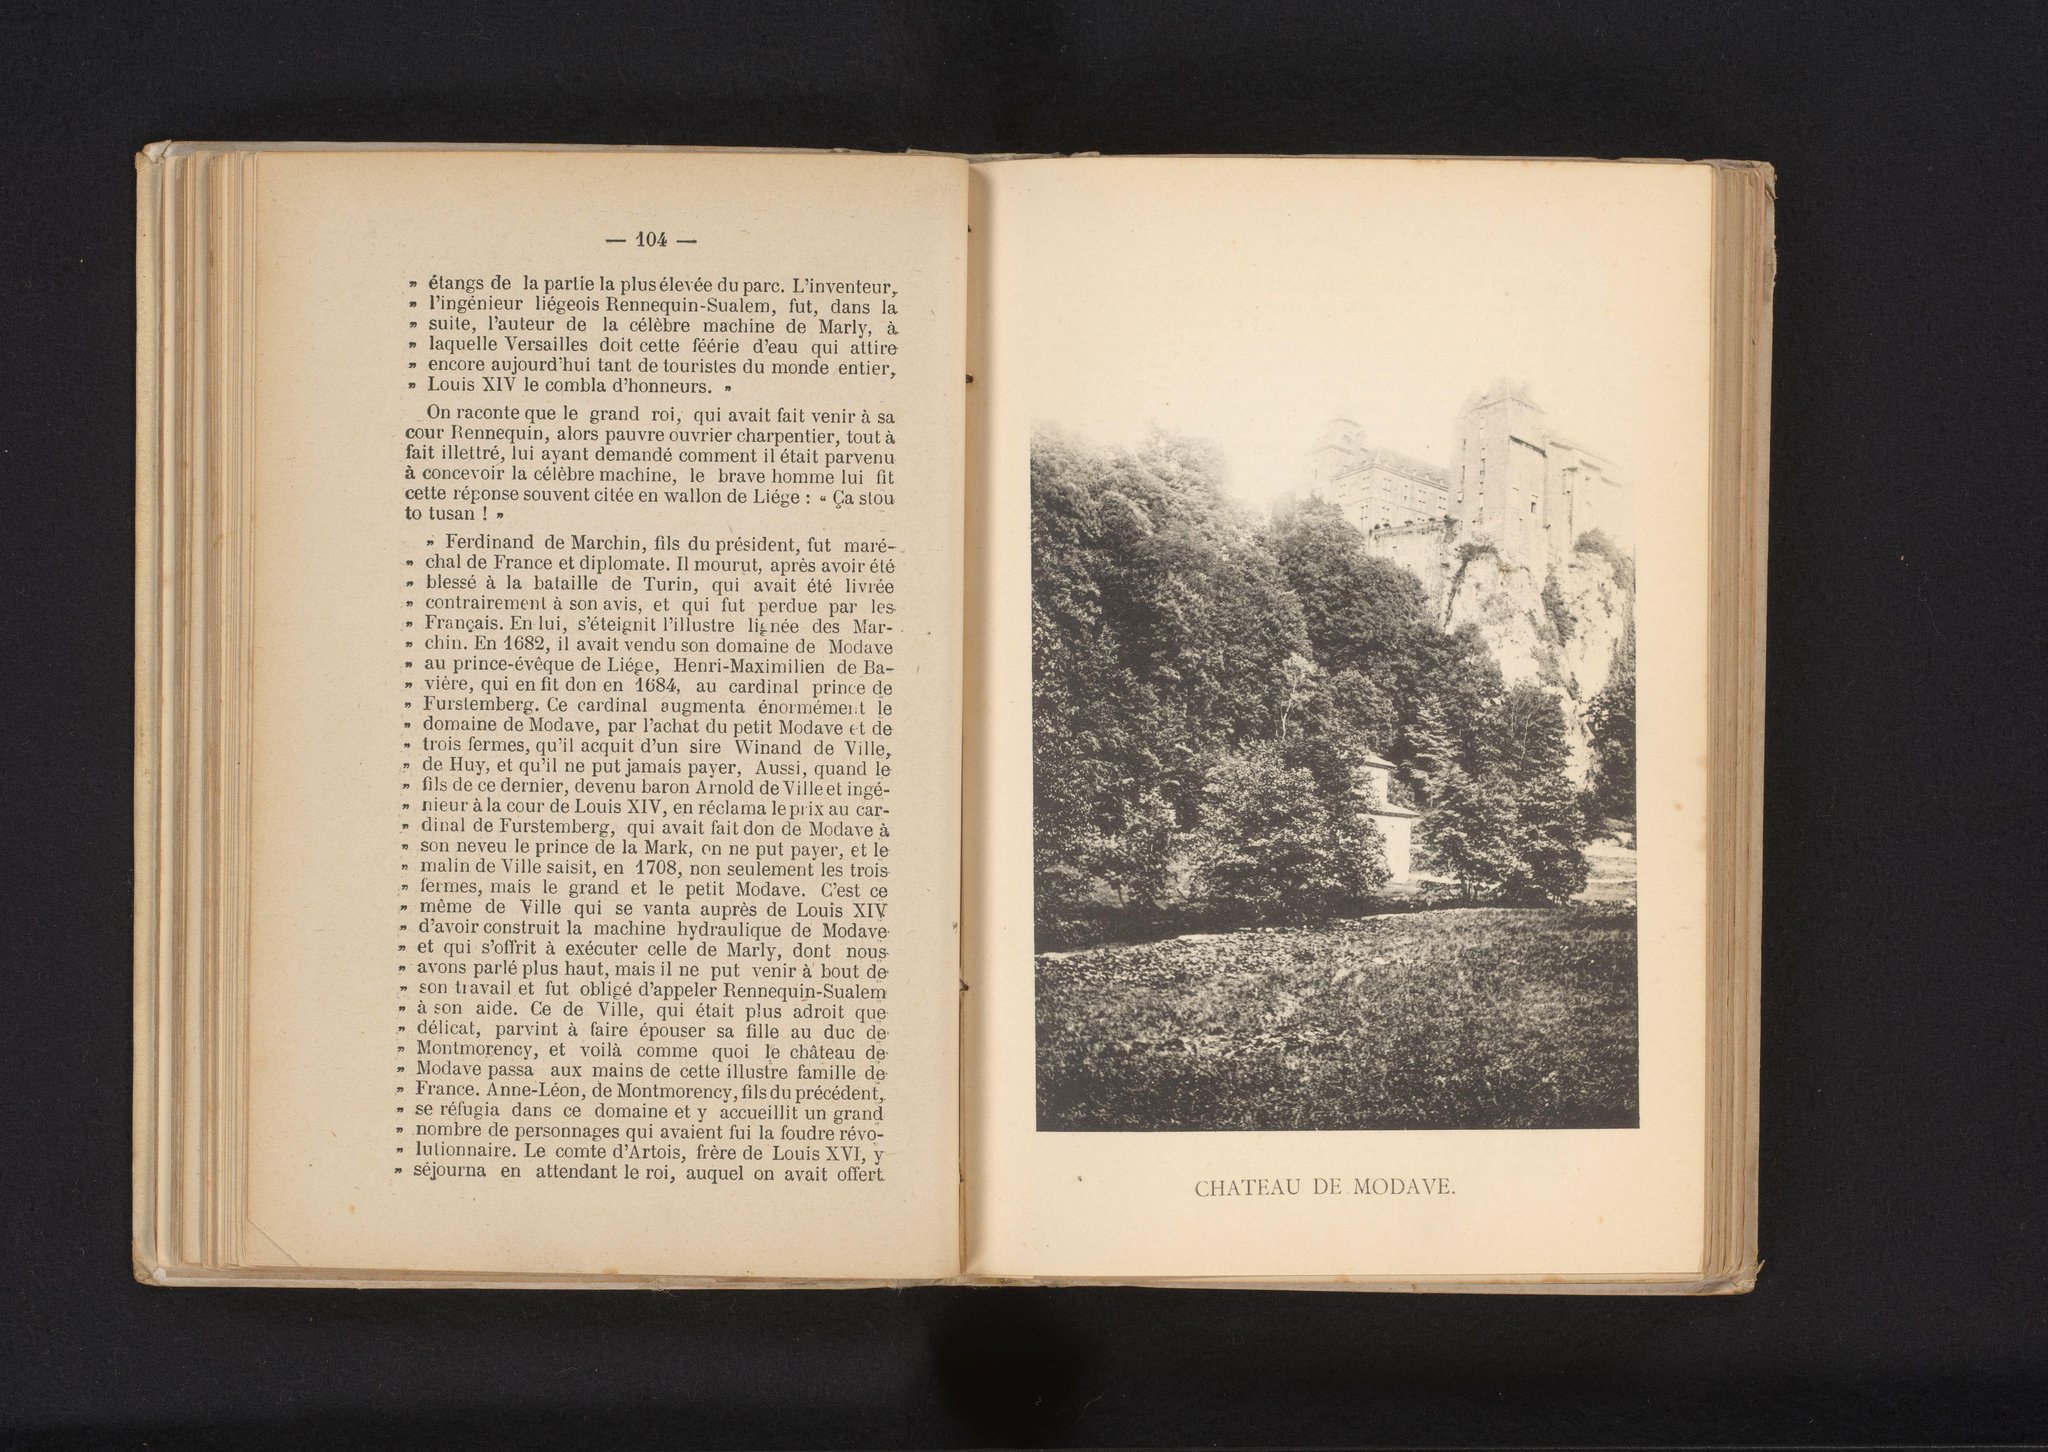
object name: photomechanical print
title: Gezicht op het kasteel van Modave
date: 1885-1890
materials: paper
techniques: photograph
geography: brussels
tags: castle